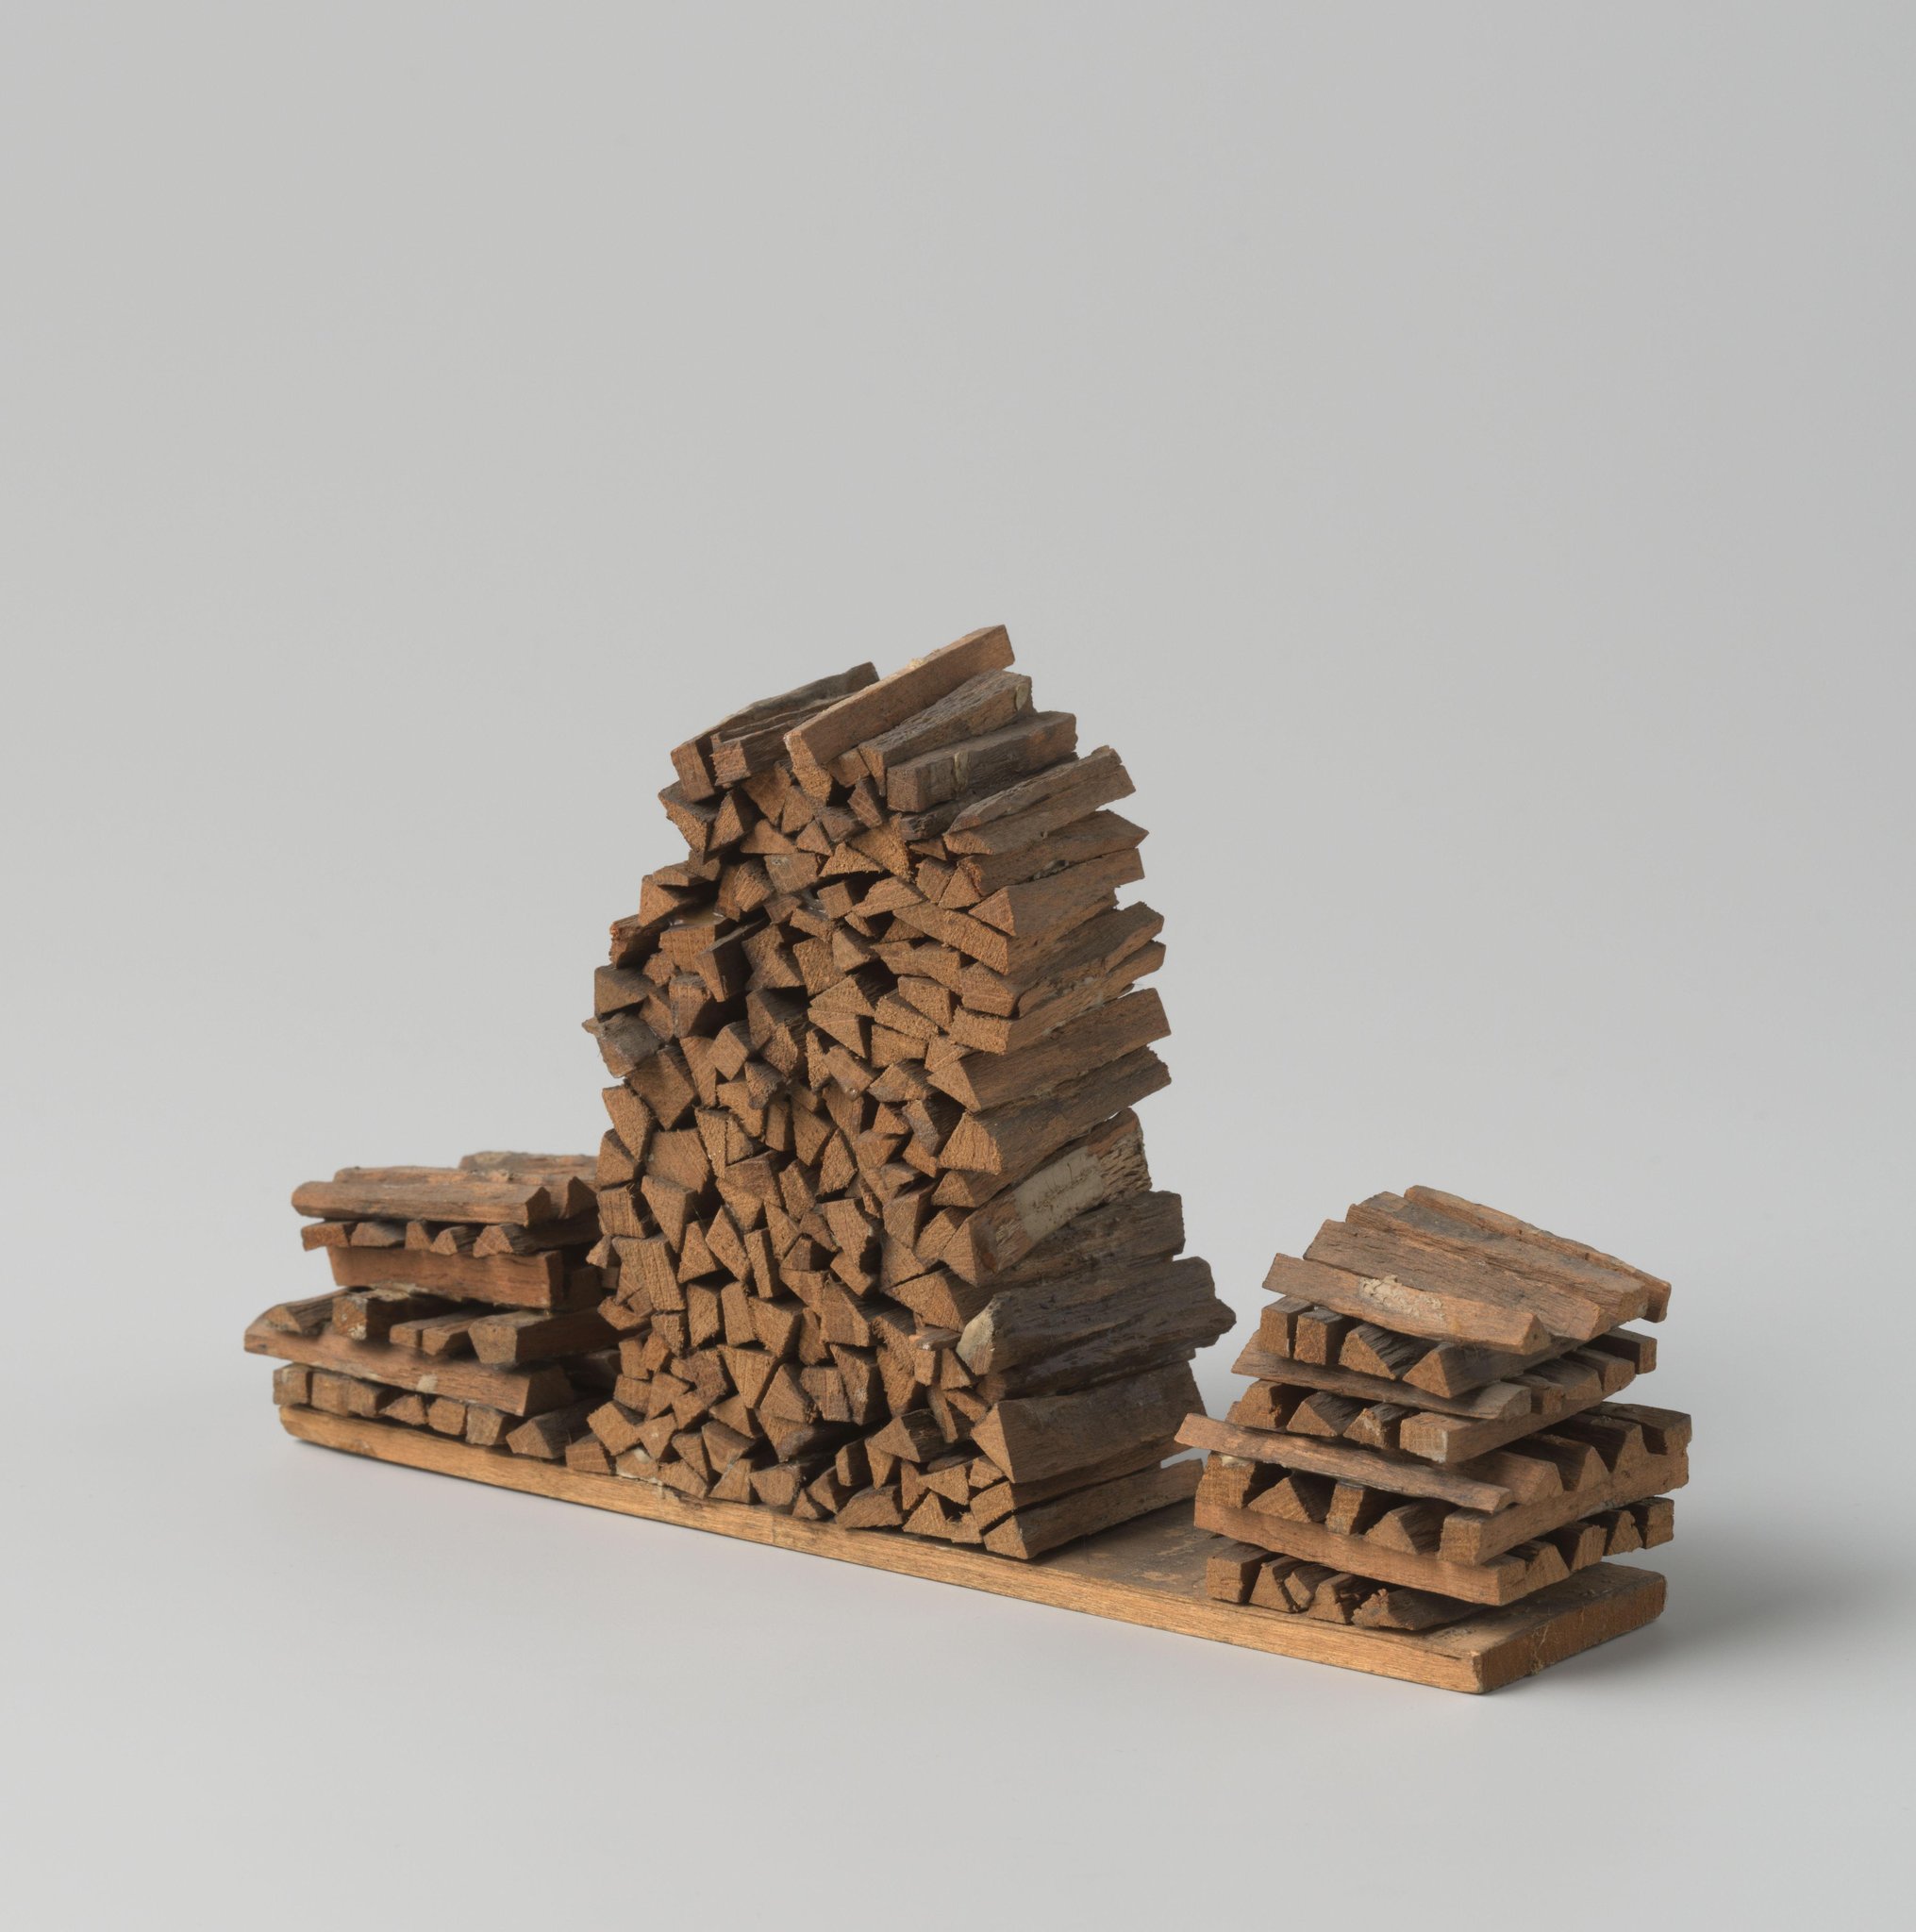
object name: brandhout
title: Plank waarop drie stapels gekloofd beukenhout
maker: Anonymous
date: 1690-1710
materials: wood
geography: amsterdam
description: Houtvoorraad, bestaande uit een eikenhouten plank, waarop drie stapels gekloofd beukenhout zijn vastgeplakt.